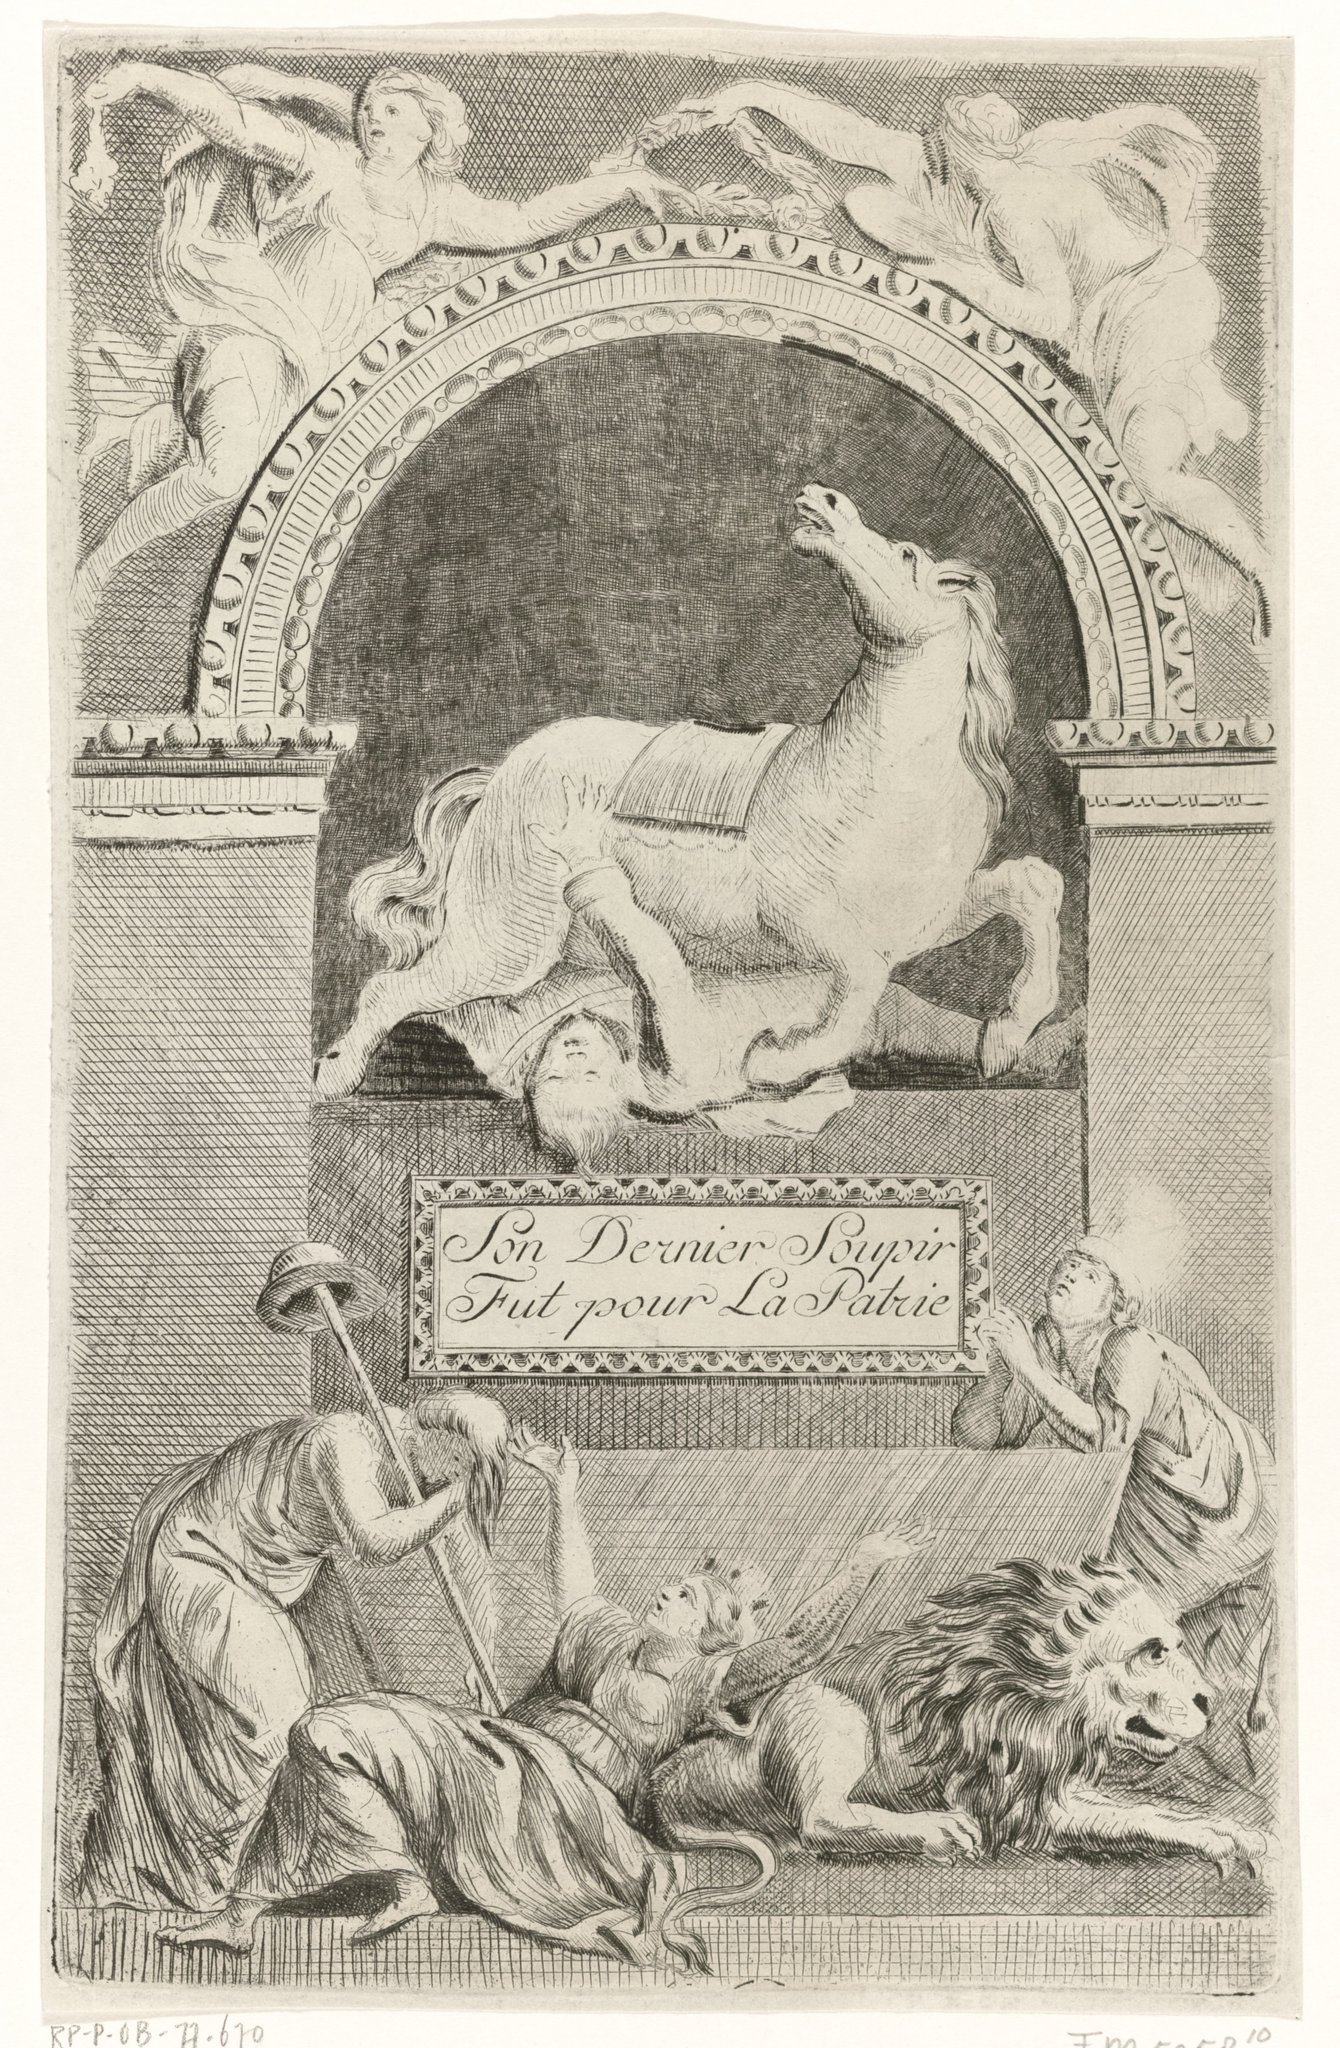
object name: print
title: Monument ter ere van kolonel-generaal Hazar, gesneuveld 3 augustus 1787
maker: Anonymous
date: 1787-1790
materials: paper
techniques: engraving, etching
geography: southern netherlands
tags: horse throwing rider, brabant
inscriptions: title: ‘Son Dernier Soupir / Fut pour la Patrie’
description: Allegorisch monument ter nagedachtenis van de Engelse kolonel-generaal Hazar van de patriotse cavalerie, gesneuveld op 3 augustus 1787 in Brussel. Een man wordt vertrapt door een paard, onderaan de treurende Vrijheid, Minerva en Brabantse leeuw. Onderdeel van een grote groep van prenten betrekking hebbend op de gebeurtenissen van de Brabantse Omwenteling en de periode 1787-1790.